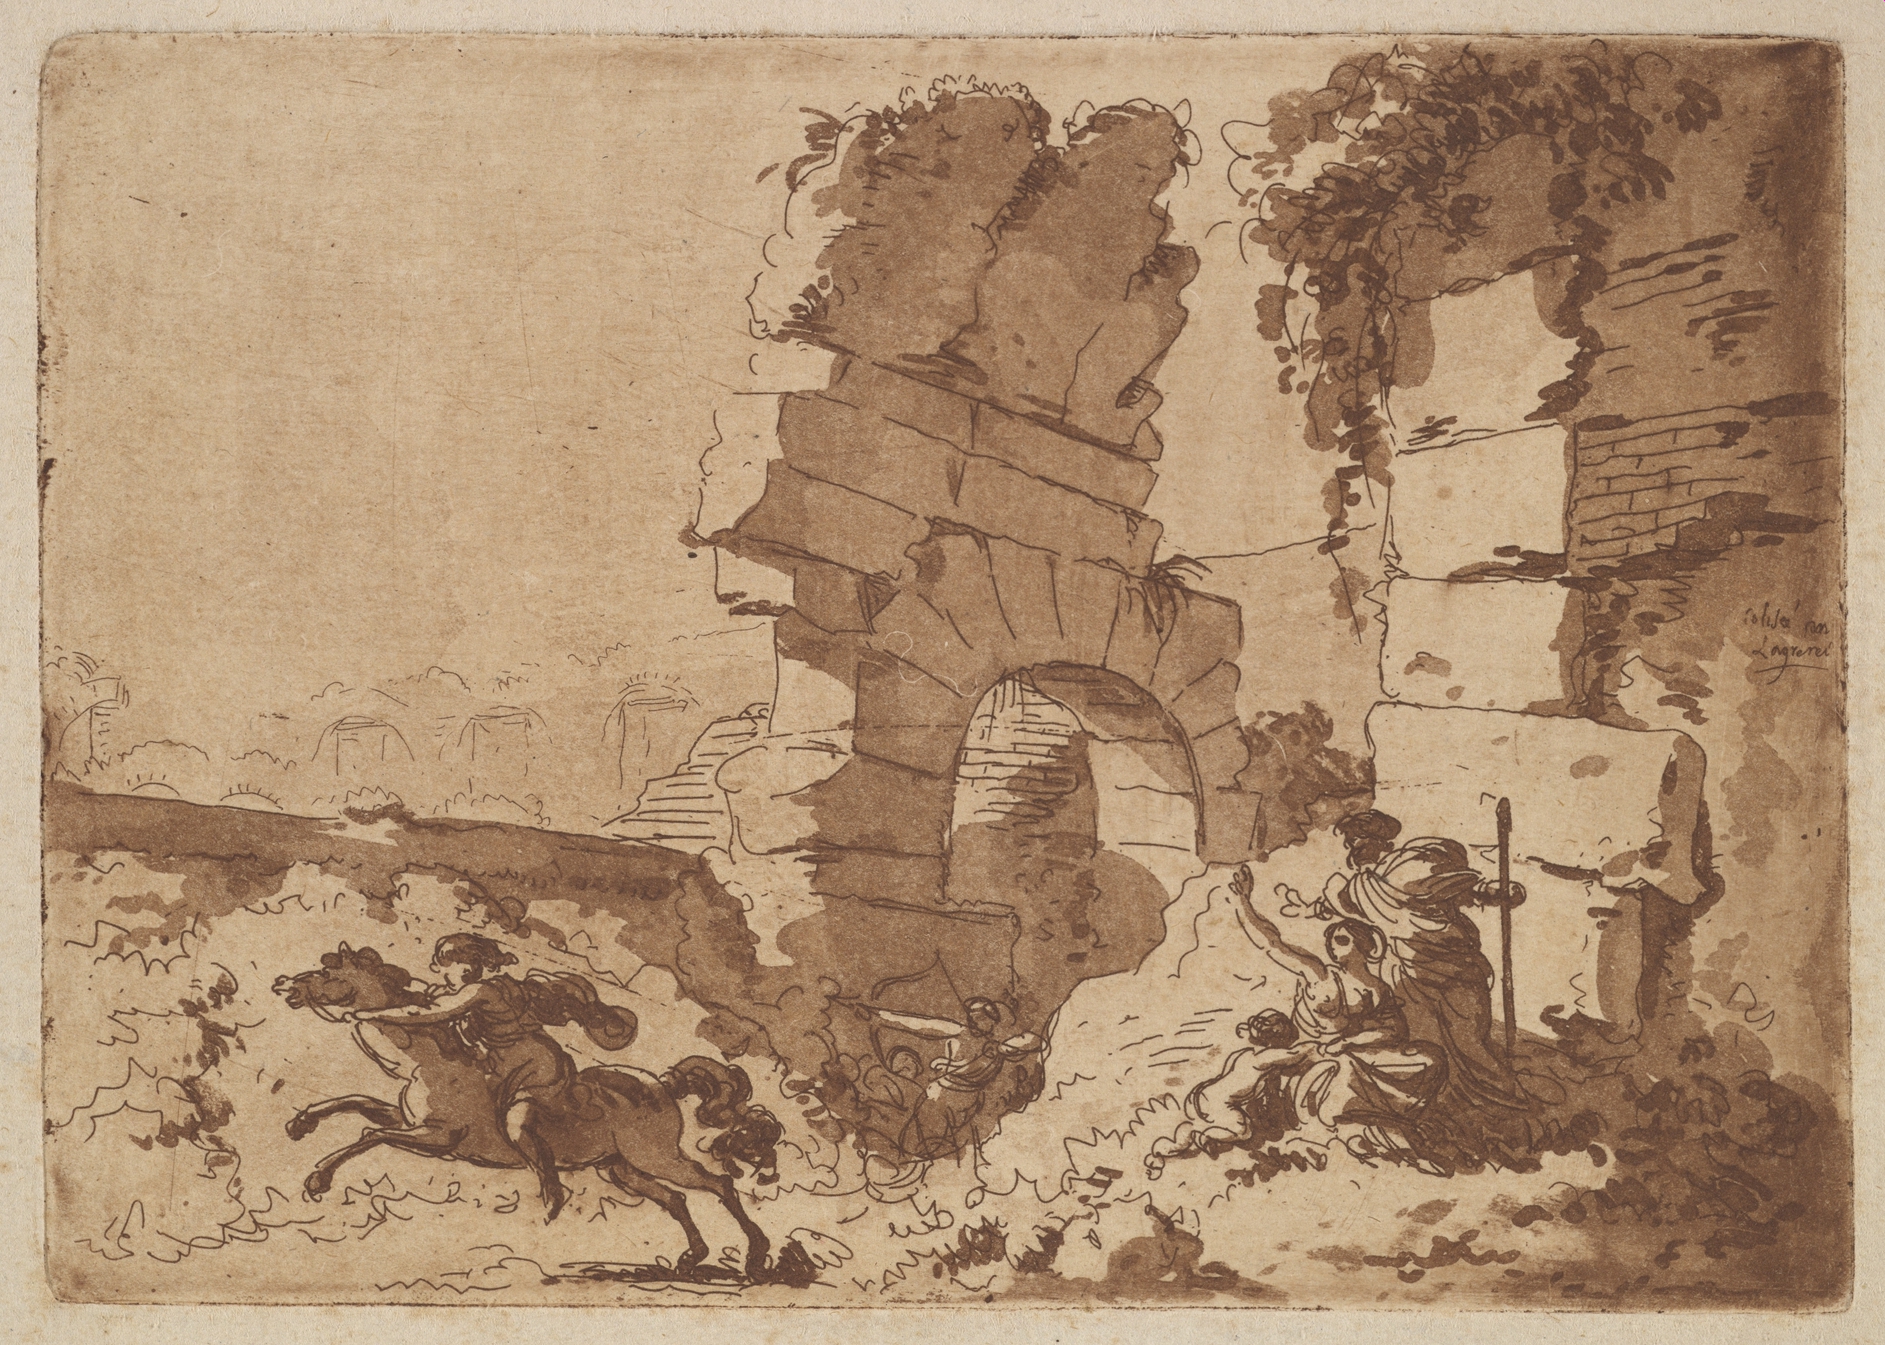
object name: print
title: Le Colisée (The Colosseum), in an album containing Recueil de Compositions par Lagrenée Le Jeune (Collection of Compositions by Lagrenée the Younger)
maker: jean jacques lagrenée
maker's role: artist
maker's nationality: french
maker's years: 1739-1821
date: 1782-1821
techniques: aquatint, etching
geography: france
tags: ruins,men,women,horses